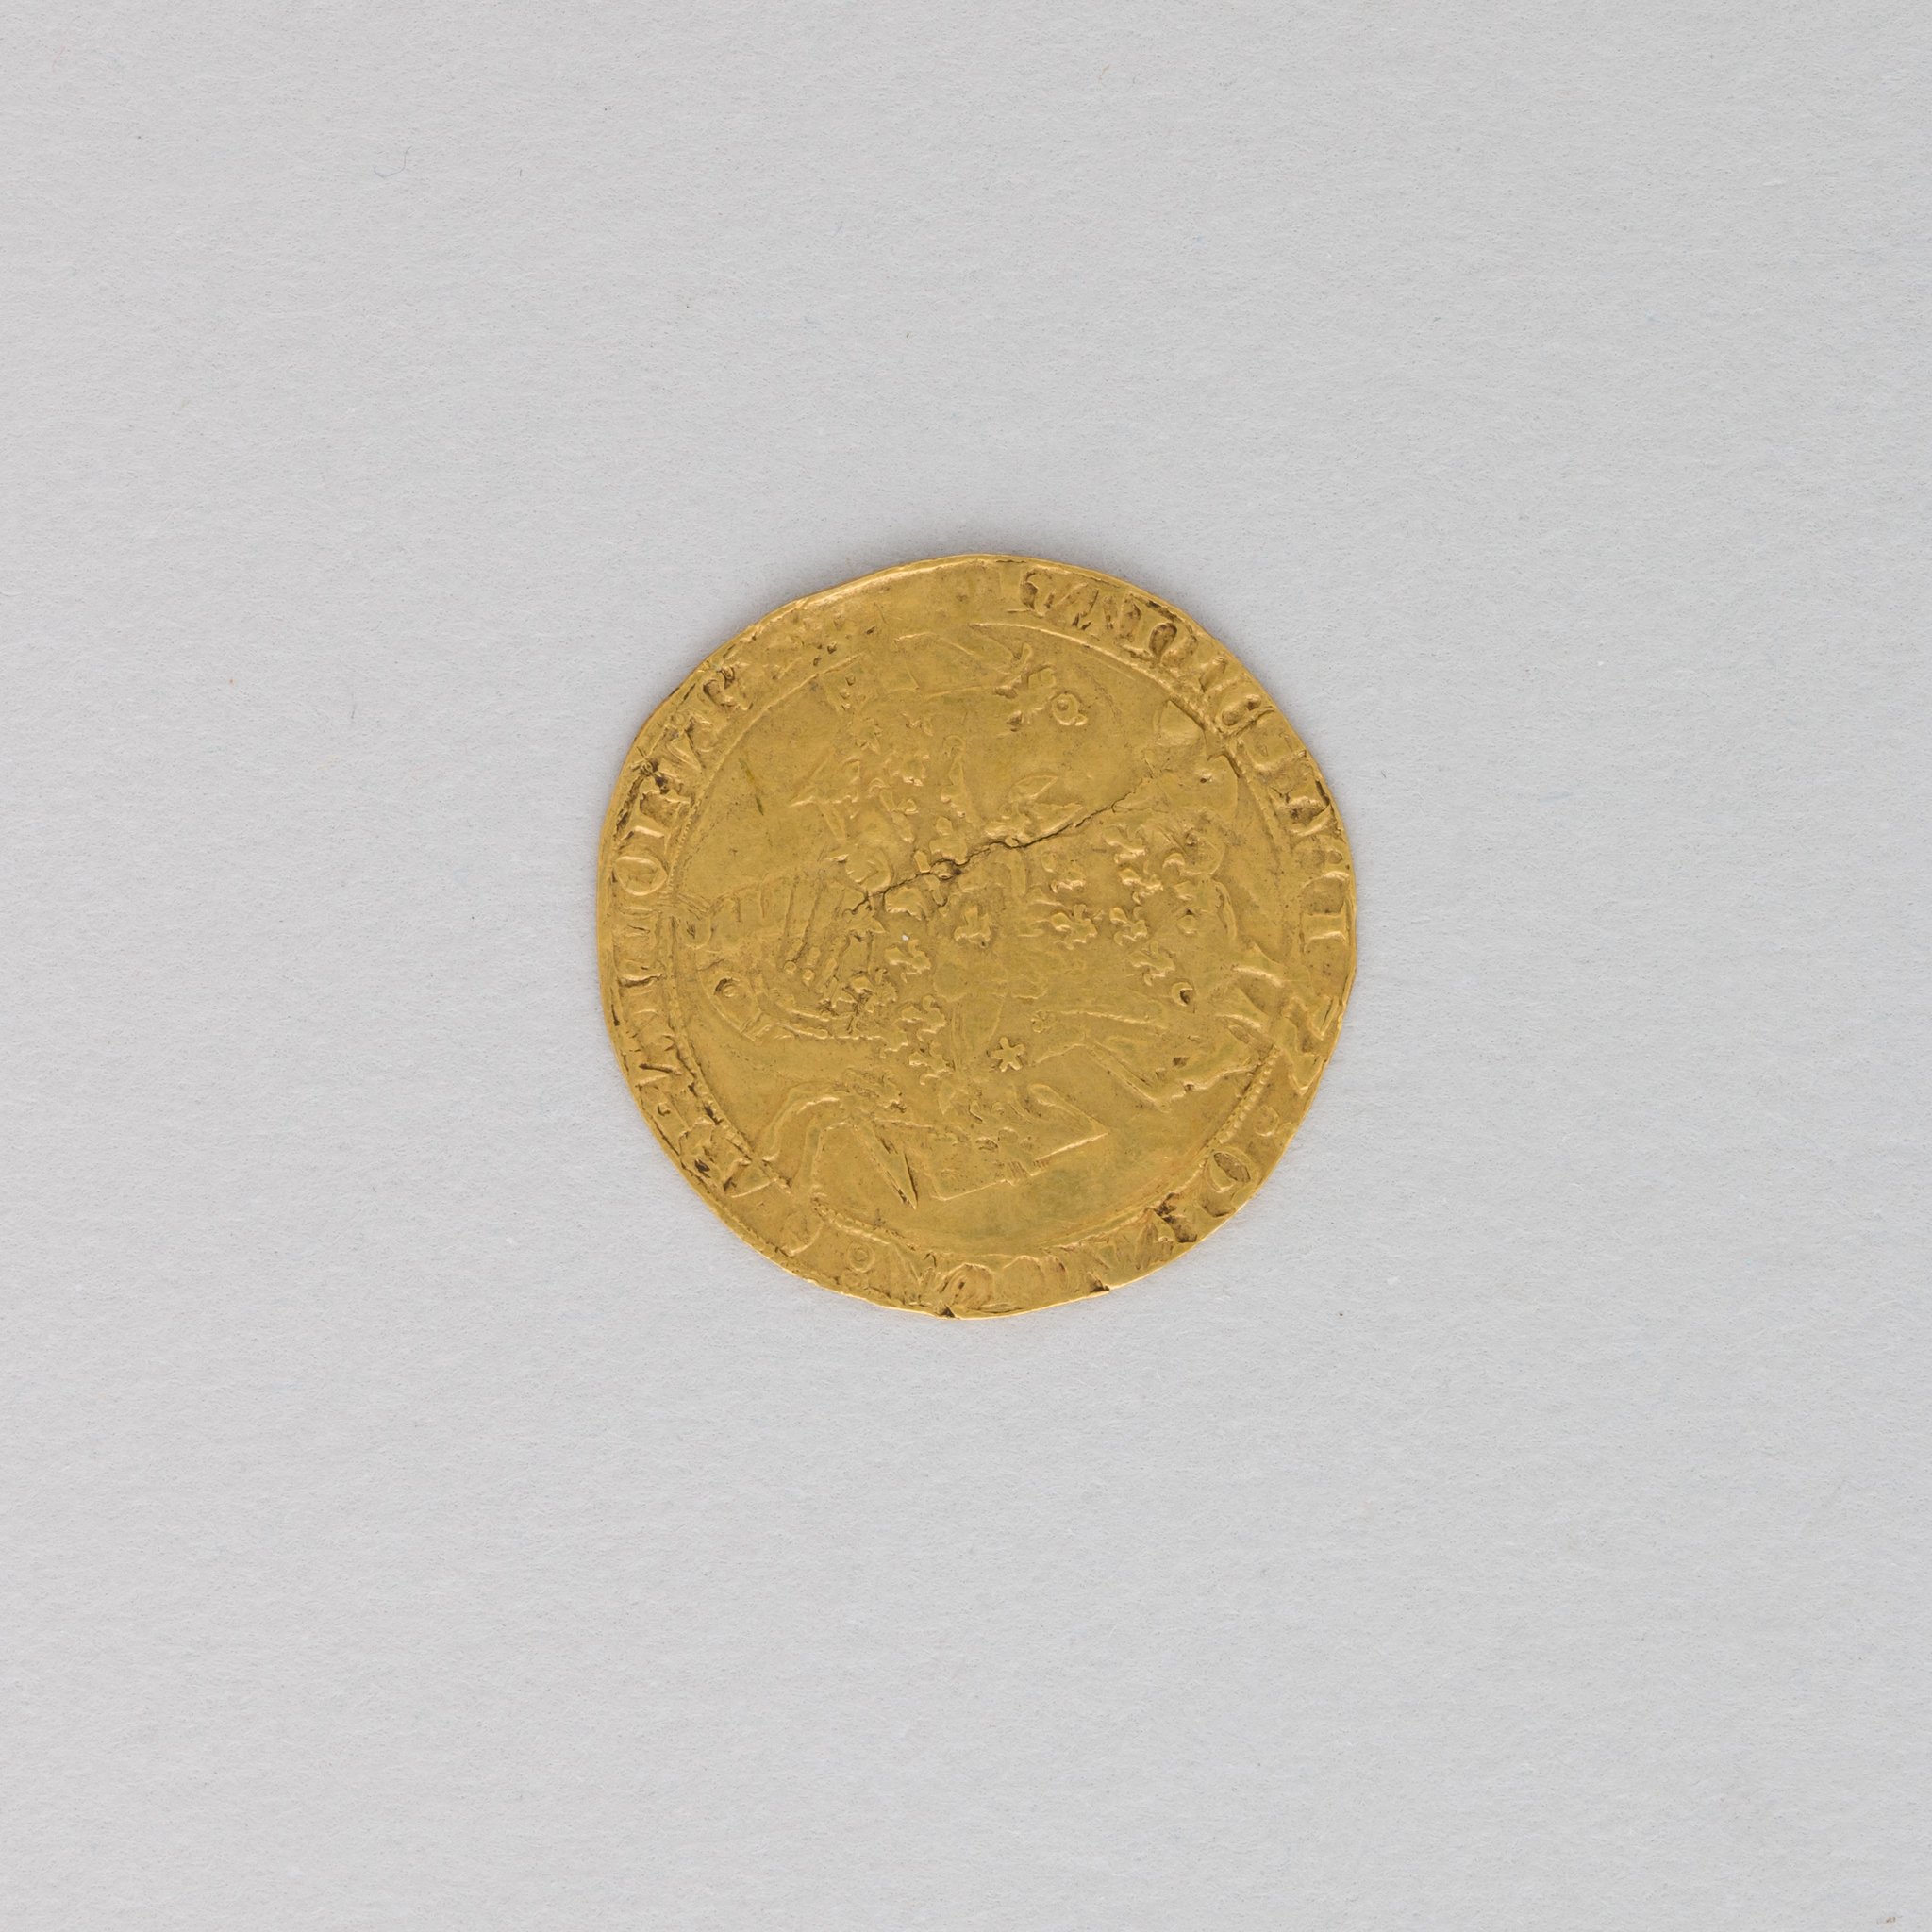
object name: coin franc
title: Coin (Franc) Showing Jean Le Bon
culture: french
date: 1350-1364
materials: gold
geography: france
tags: coins